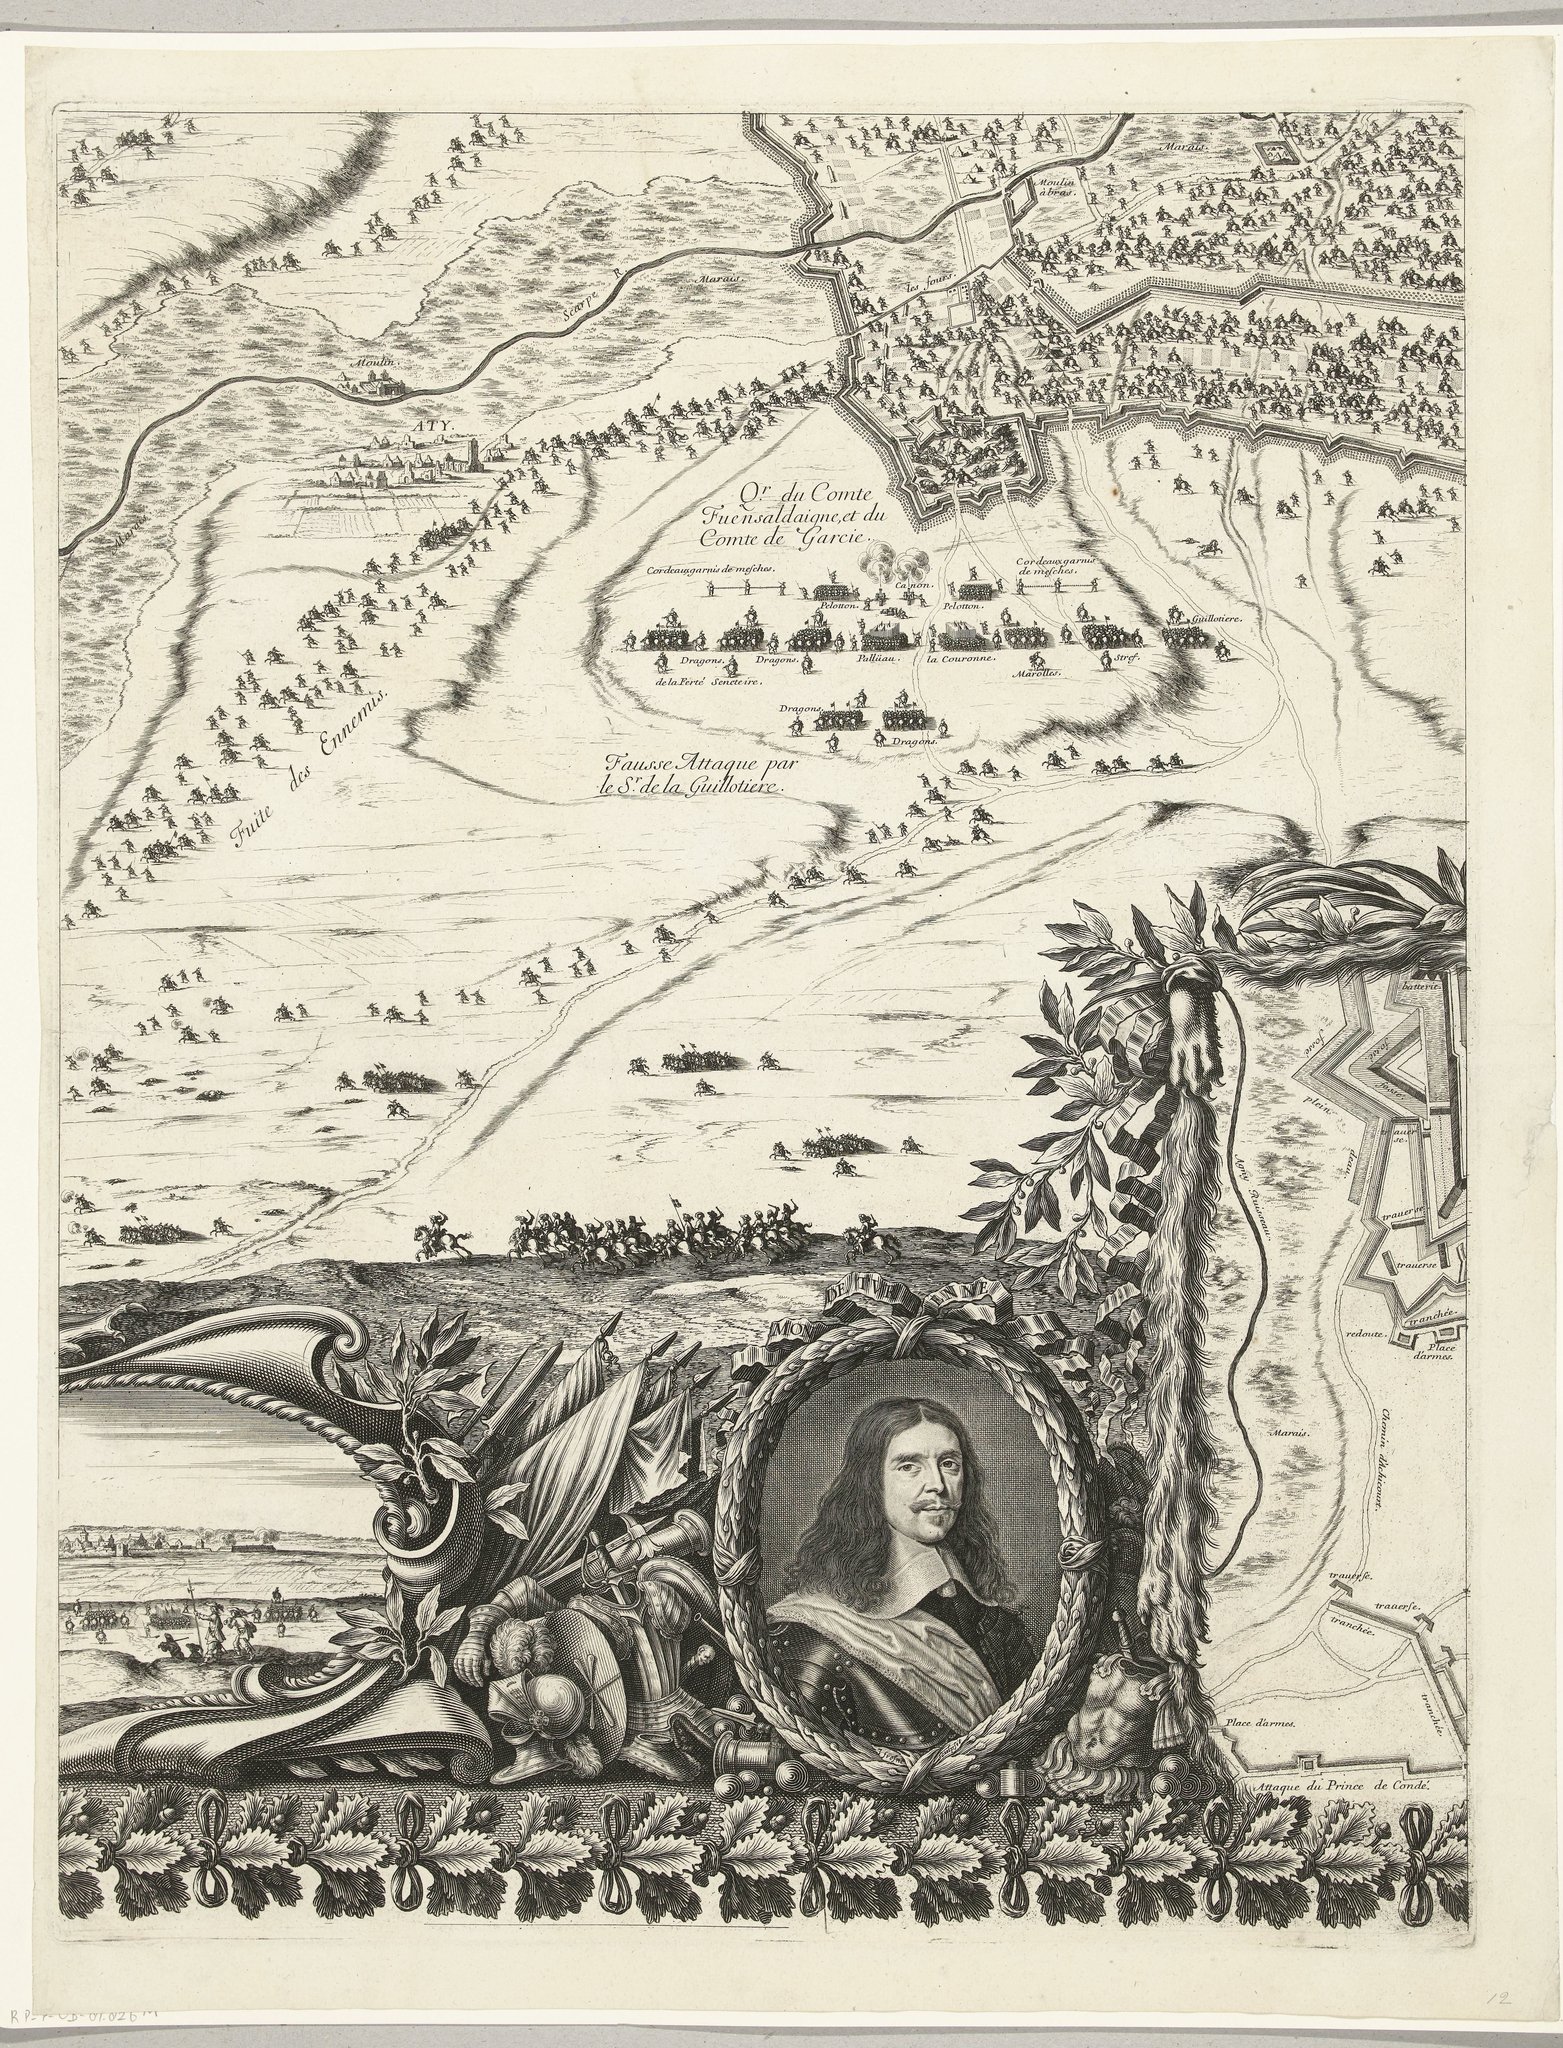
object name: propagandaprent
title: Le siege d'Arras leve par la defaite des ennemis 1654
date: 1655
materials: paper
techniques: engraving, etching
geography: france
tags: vienna, leopold willem van oostenrijk (landvoogd der zuidelijke nederlanden), raising the siege with outside assistance, relief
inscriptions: date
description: Ontzet van de stad Arras (Atrecht), belegerd door de Spanjaarden, 23-25 augustus 1654. Arras ontzet door het Franse leger onder de maarschalk Turenne van het beleg door de Spanjaarden onder Louis de Condé en aartshertog Leopold Willem. Tweede blad in de onderste rij. Deel van de kaart van het beleg met vluchtende troepen, onderaan een deel van de cartouche met de inname van St. Paul, een portret van maarschalk Turenne en een deel van een inzet met een detailvoorstelling van de verdedigingswerken van de stad. Onderdeel van een ongemonteerd geheel bestaande uit een titelblad en een grote voorstelling op vijftien platen (de halve plaat rechtsonder ontbreekt).